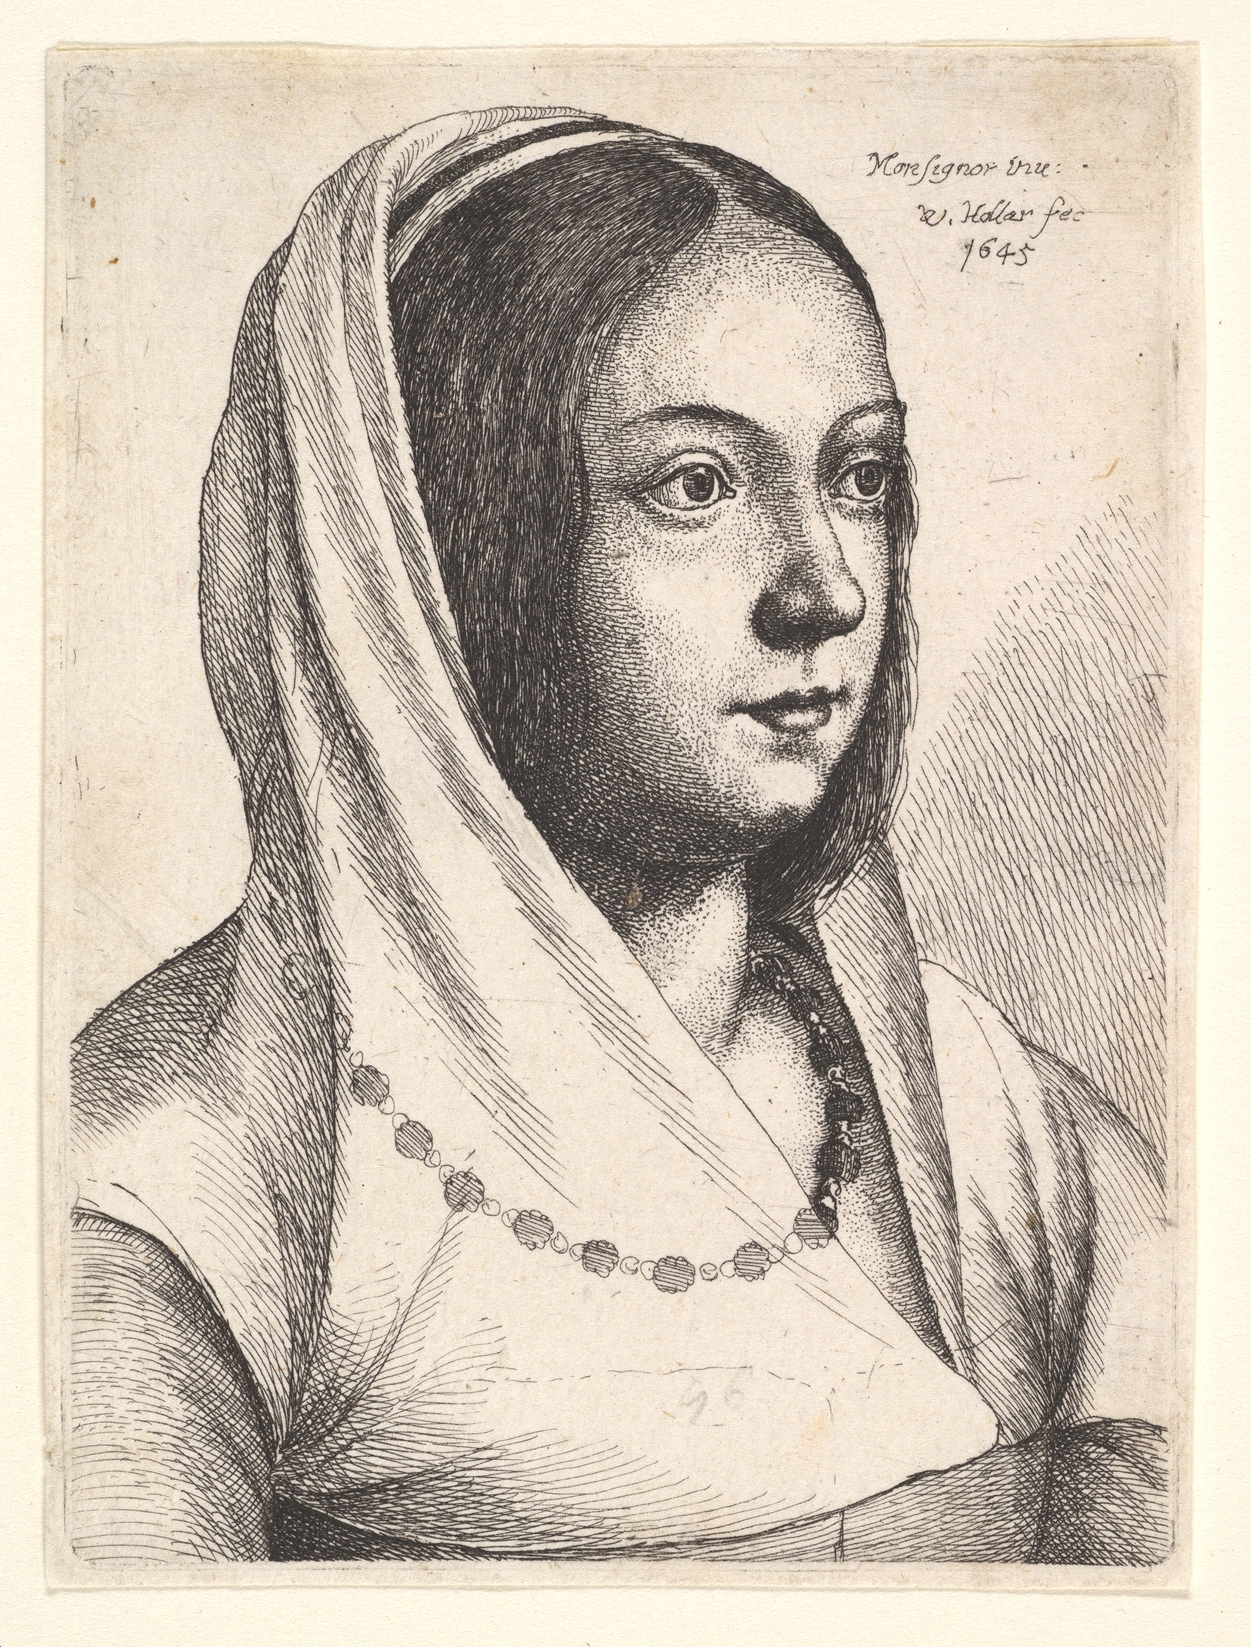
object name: print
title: Young woman with a scarf on her head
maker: wenceslaus hollar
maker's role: artist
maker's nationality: bohemian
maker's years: 1607-1677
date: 1645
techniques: etching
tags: portraits,women